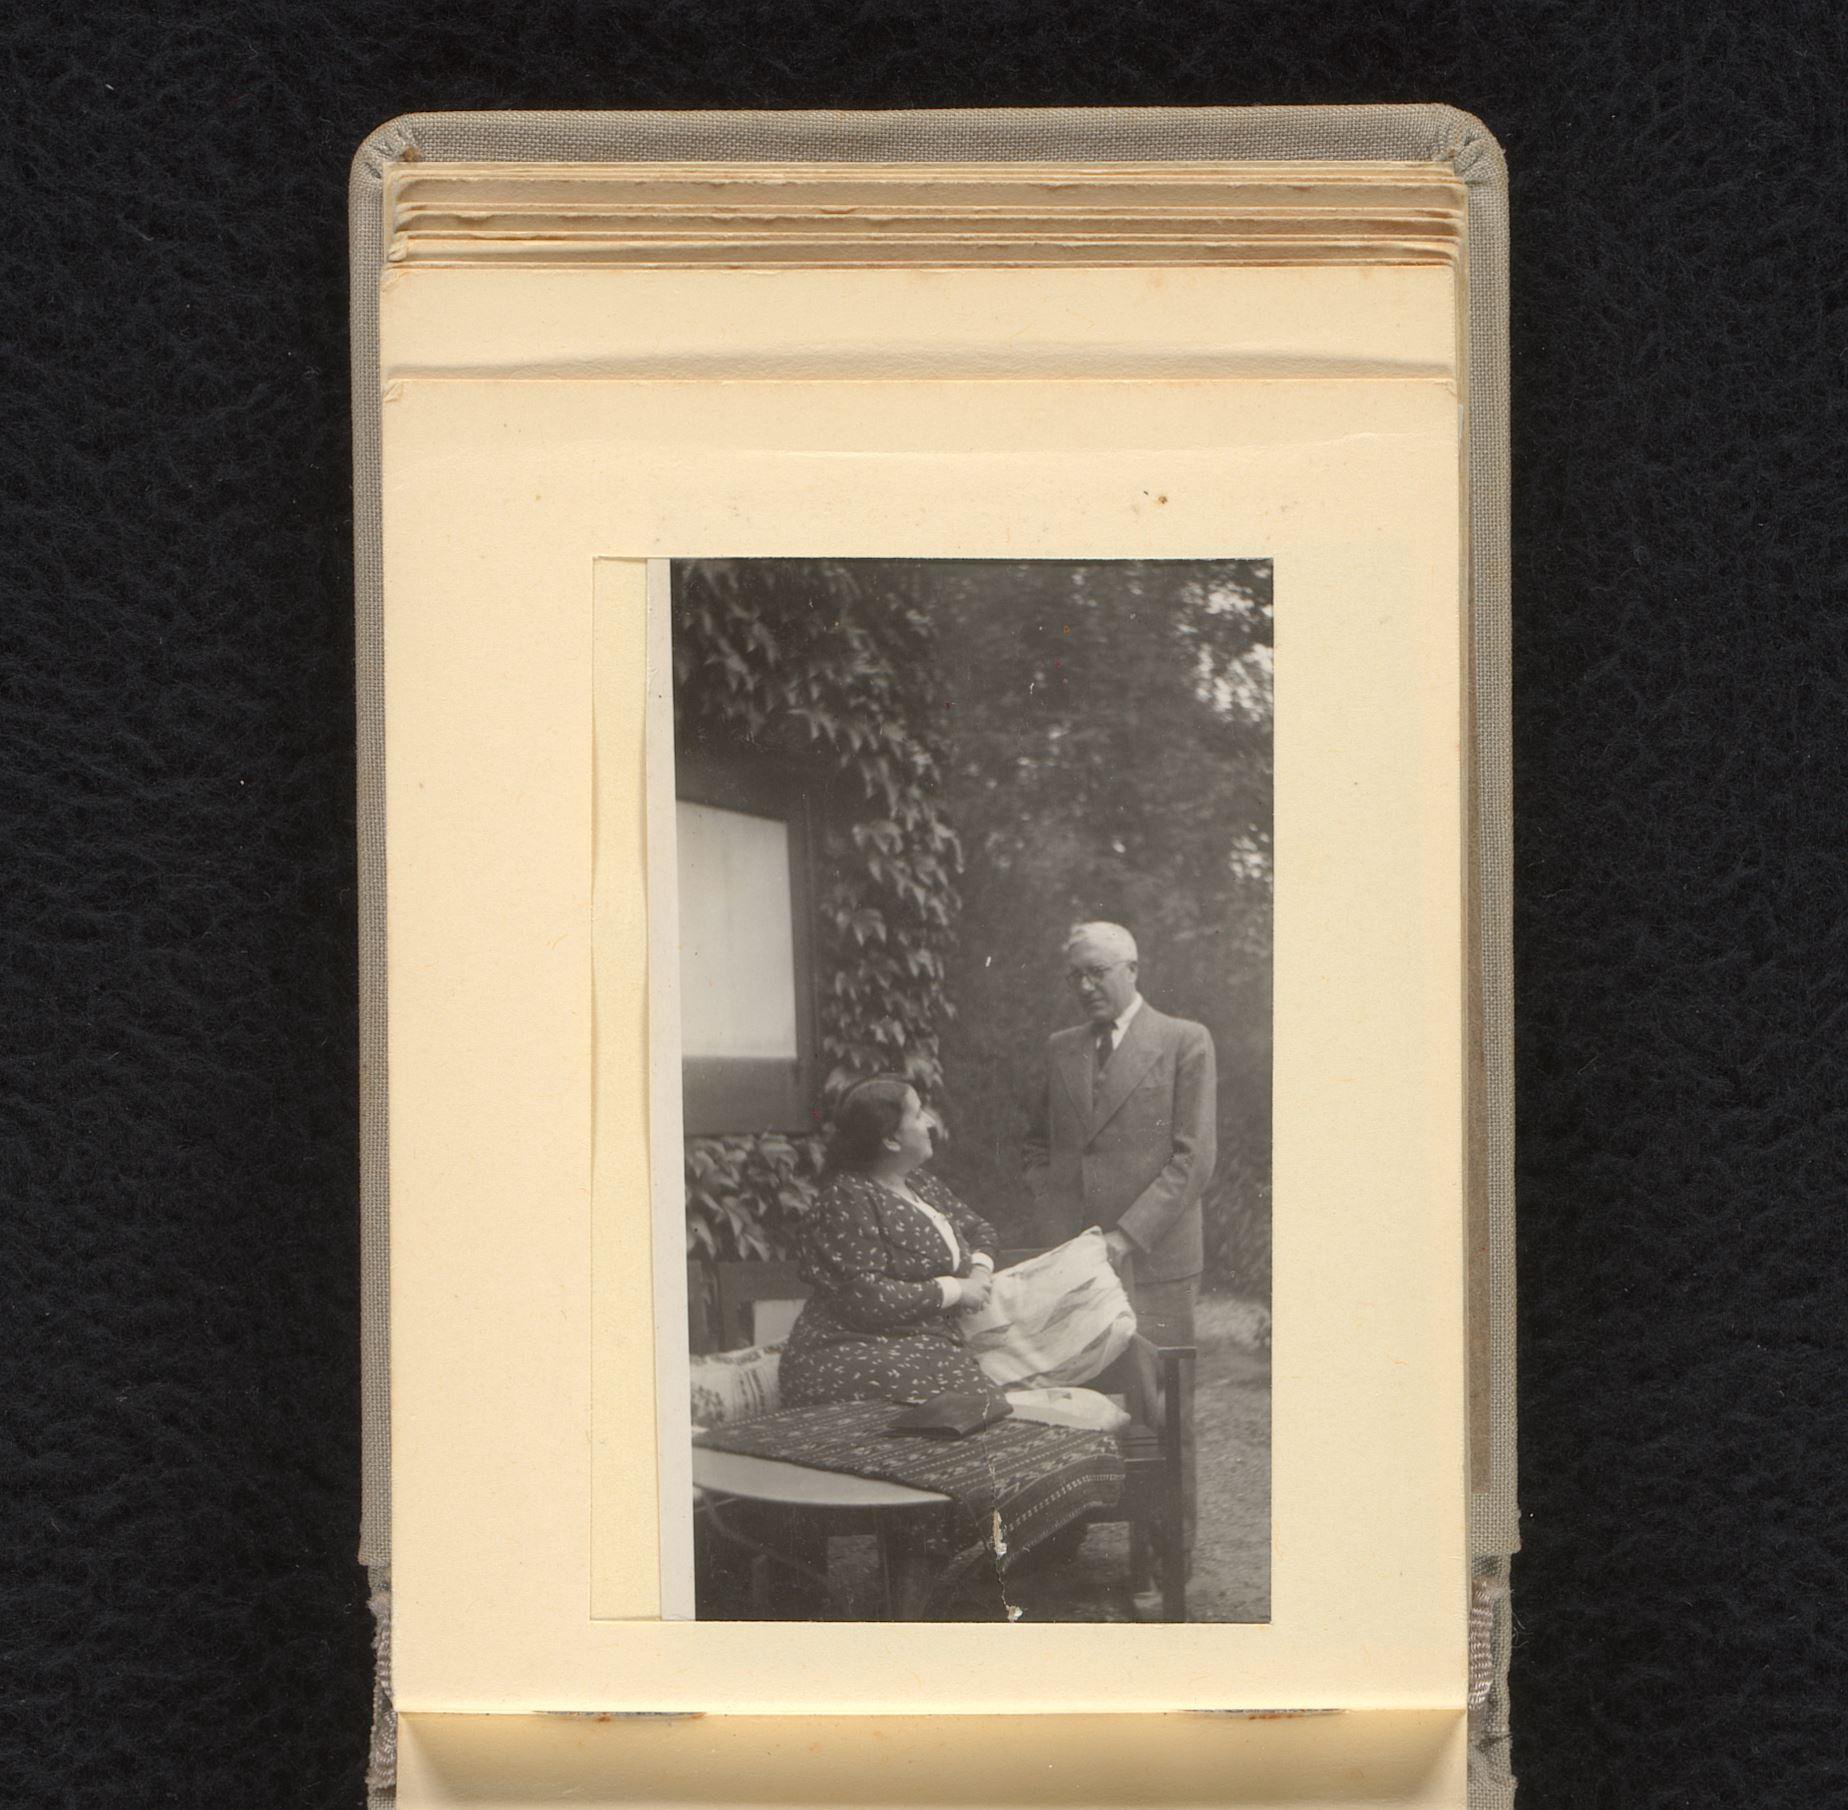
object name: album leaf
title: Else Wachenheimer-Moos in de tuin met haar echtgenoot Eugen Wachenheimer, 1941 Doorn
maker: isabel wachenheimer-elon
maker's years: 1928-2010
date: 1941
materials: paper, photographic support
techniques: gelatin silver print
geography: doorn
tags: eugen wachenheimer, else wachenheimer-moos, family life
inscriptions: inscription: ‘Doorn 1941.’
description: Albumblad bevat een foto van Else Wachenheimer-Moos (links) en Eugen Wachenheimer (rechts), in de tuin in Doorn, 1941. Onderdeel van het fotoalbum met diverse foto's van de jeugd van Isabel Wachenheimer voor en tijdens de oorlog en diverse momenten van haar volwassen leven na de Tweede Wereldoorlog.